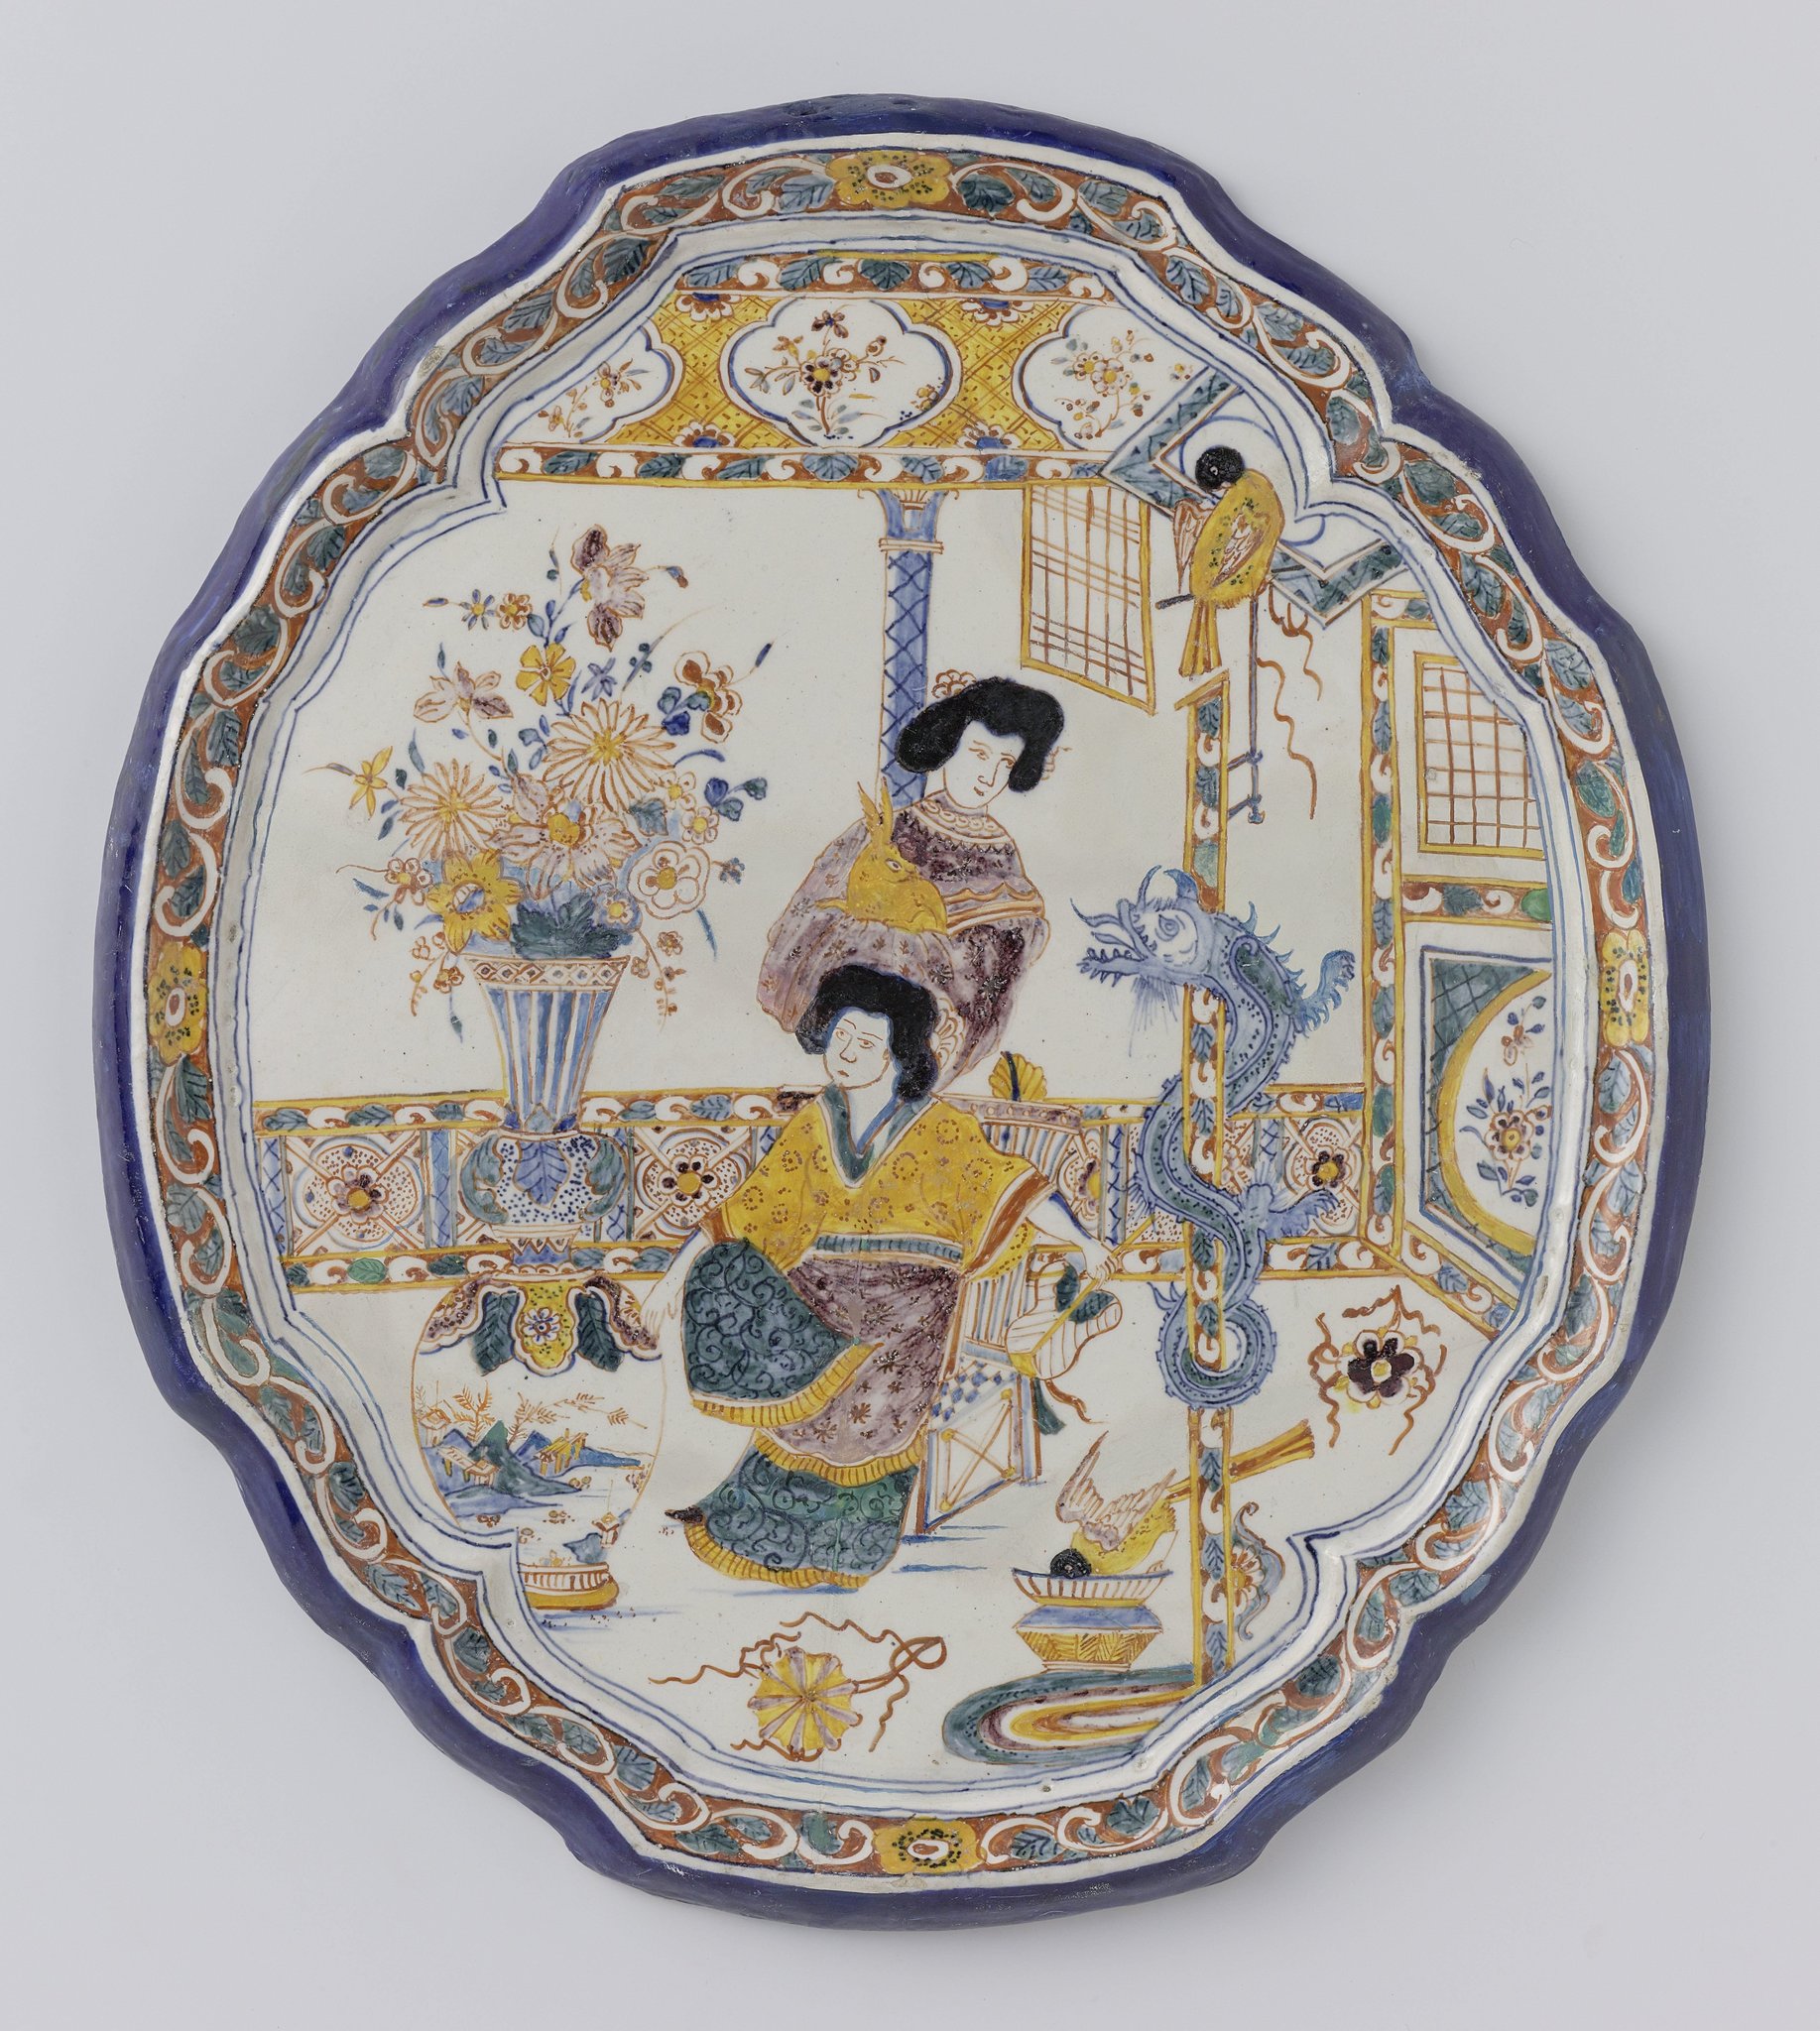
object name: plate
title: Plaat, ovaal met uitgeschulpte rand. Veelkleurig beschilderd met Chinese vrouwen met bloemen en vogels op een terras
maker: Anonymous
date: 1720-1760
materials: faience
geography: delft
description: Plaat van faïence, ovaal met uitgeschulpte rand. Veelkleurig beschilderd met Chinese vrouwen met bloemen en vogels op een terras.